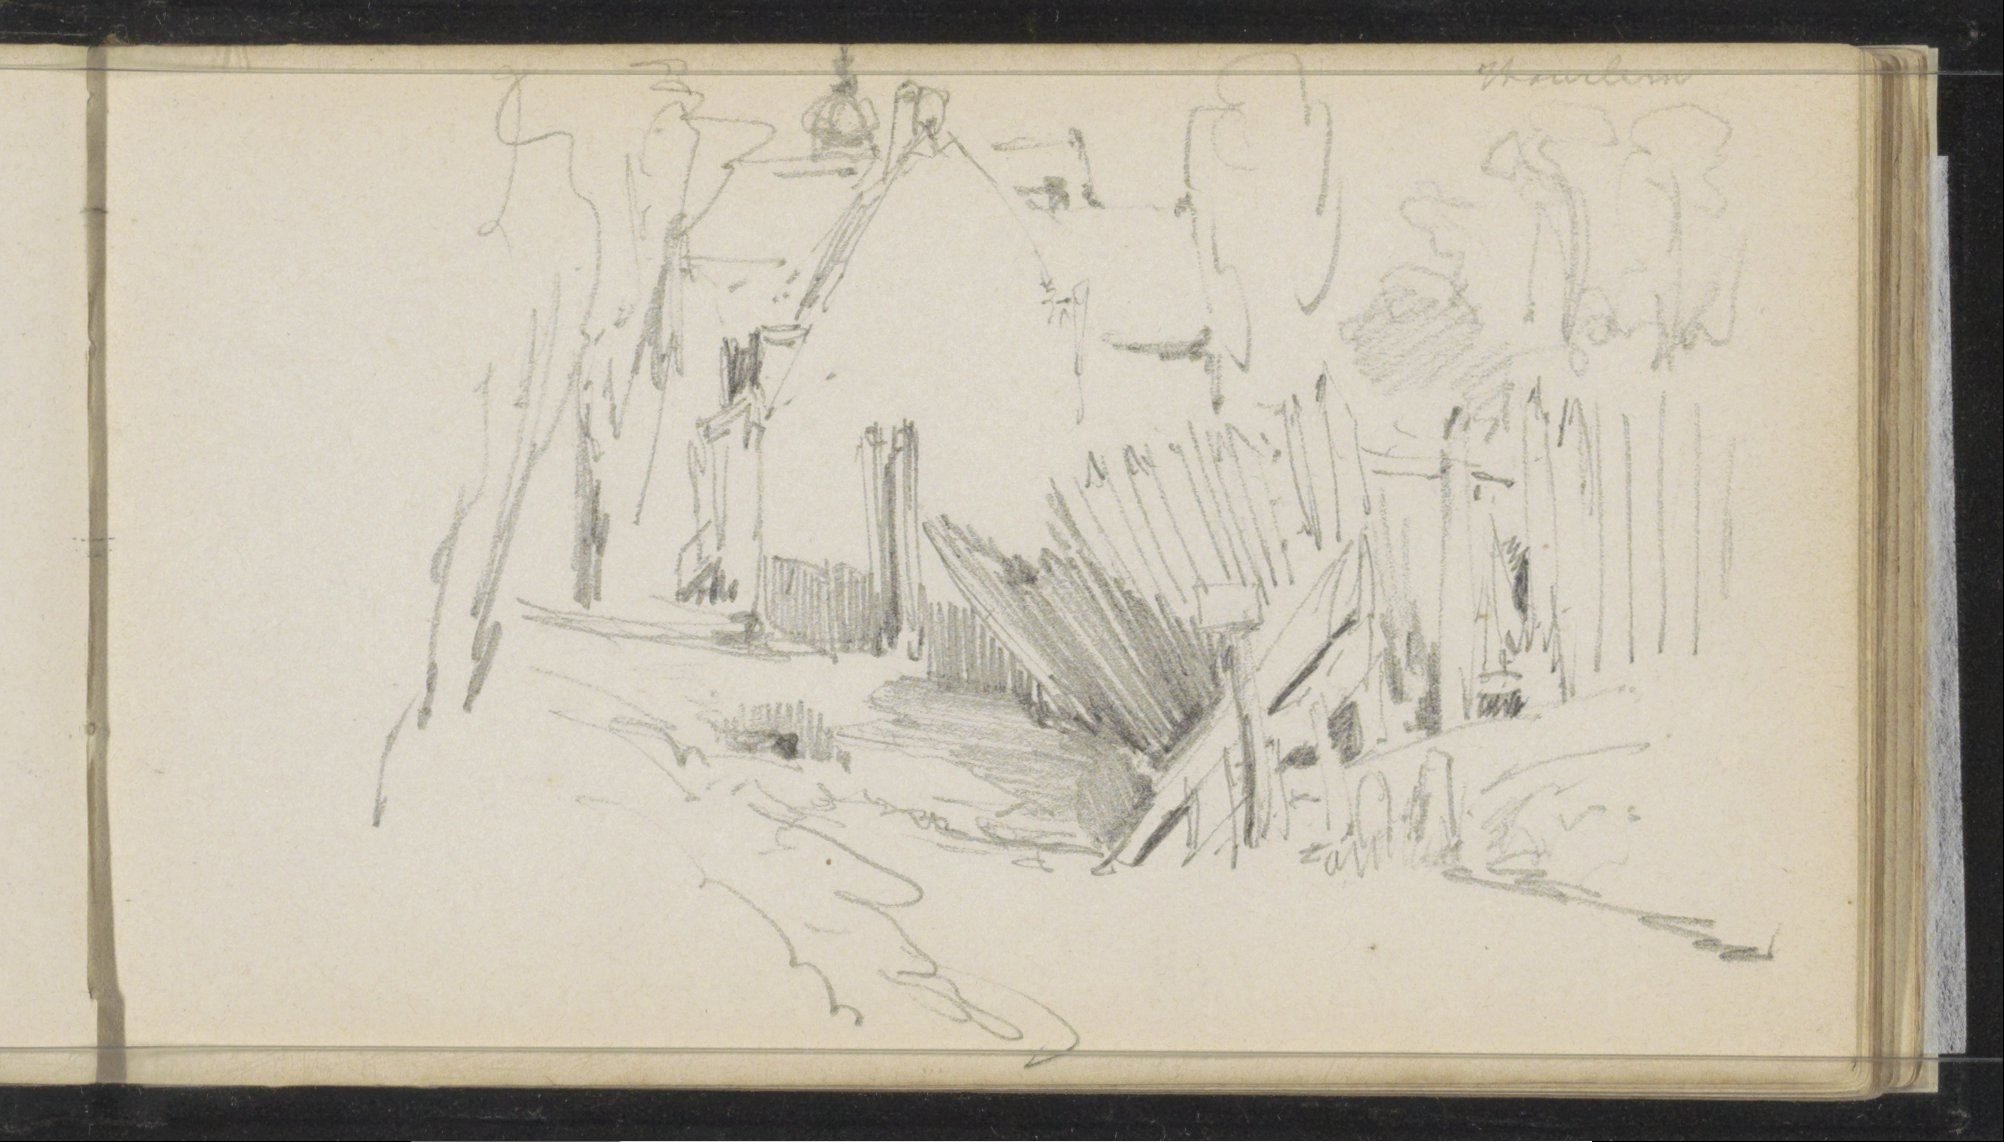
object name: sketchbook leaf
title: Gezicht in Haarlem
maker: cornelis springer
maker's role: draughtsman, painter, print maker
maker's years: 1817-1891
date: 1860-1866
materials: paper, pencil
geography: netherlands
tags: urban housing, city-view, and landscape with man-made constructions, haarlem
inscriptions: annotation: ‘Haarlem’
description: Gezicht op huizen en een hek in Haarlem. Blad 22 recto uit een schetsboek met 44 bladen.